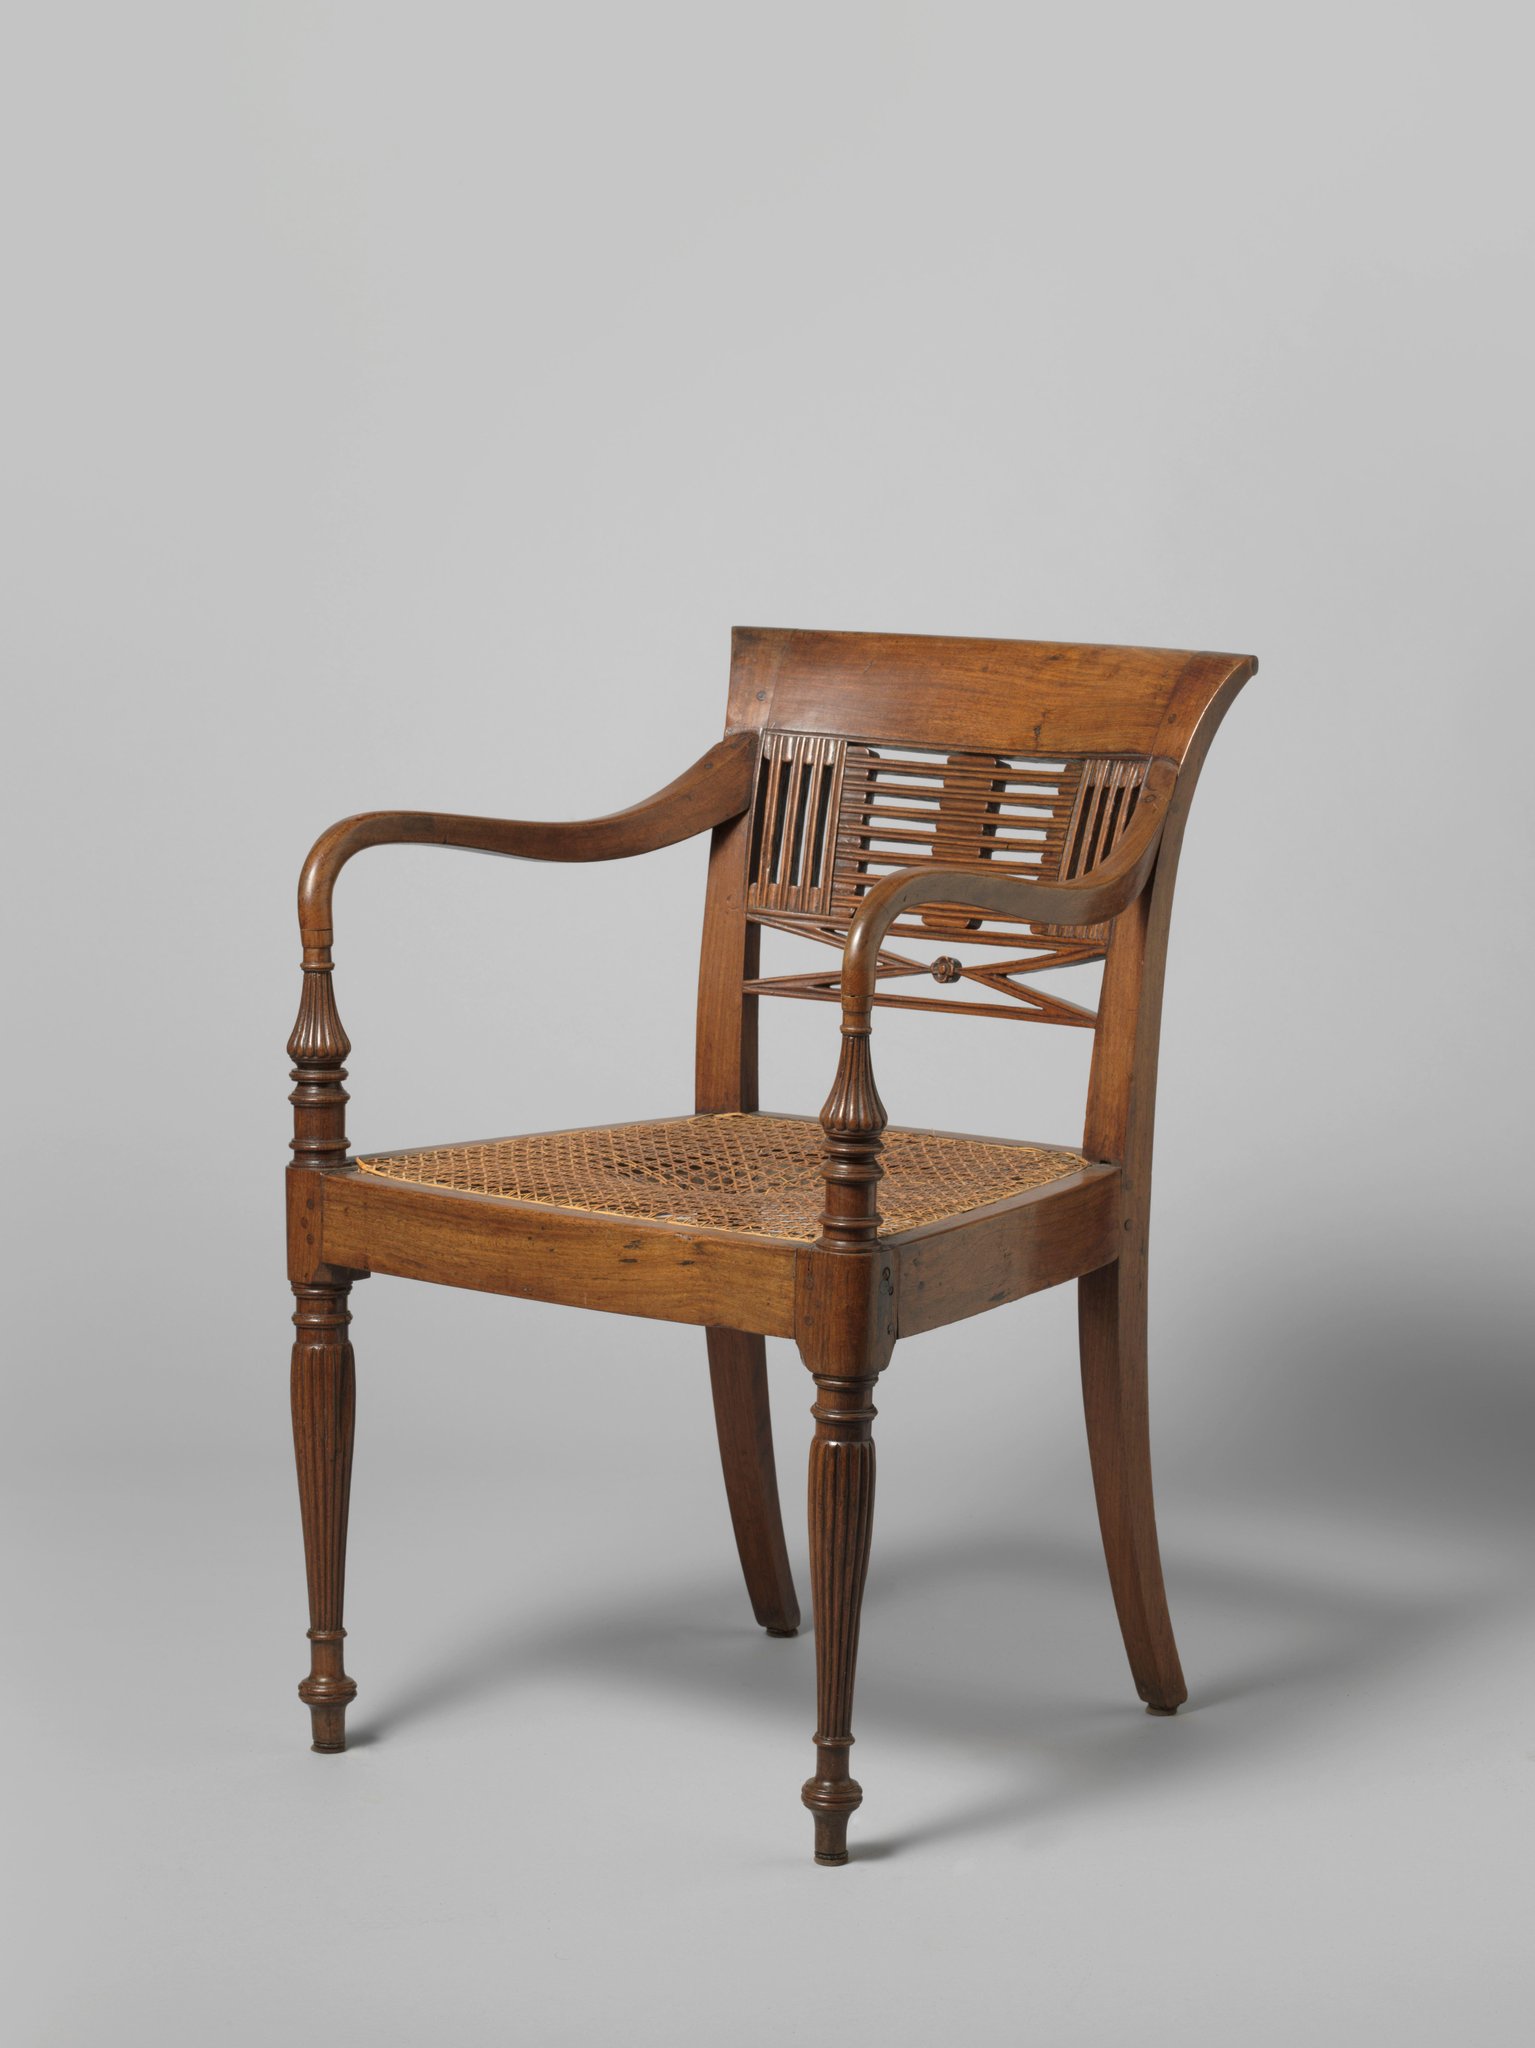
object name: armchair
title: Armstoel van teakhout en met rotan bespannen zitting, z.g. 'Raffles' stoel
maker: Anonymous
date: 1800-1810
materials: rattan, wood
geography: indonesia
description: Armstoel van teakhout met met rotan bespannen zitting ('Raffles-stoel'). De stoel rust op balustervormige geribde voorpoten en sabelvormige achterpoten die overgaan in de naar achteren gewelfde rugstijlen. De rug heeft een brede bovendorpel waaronder een opengewerkt veld met horizontale en verticale spijlen boven een veld met gekruiste spijlen. De gebogen armen eindigen in geribde uivormen op gedraaide stutten.